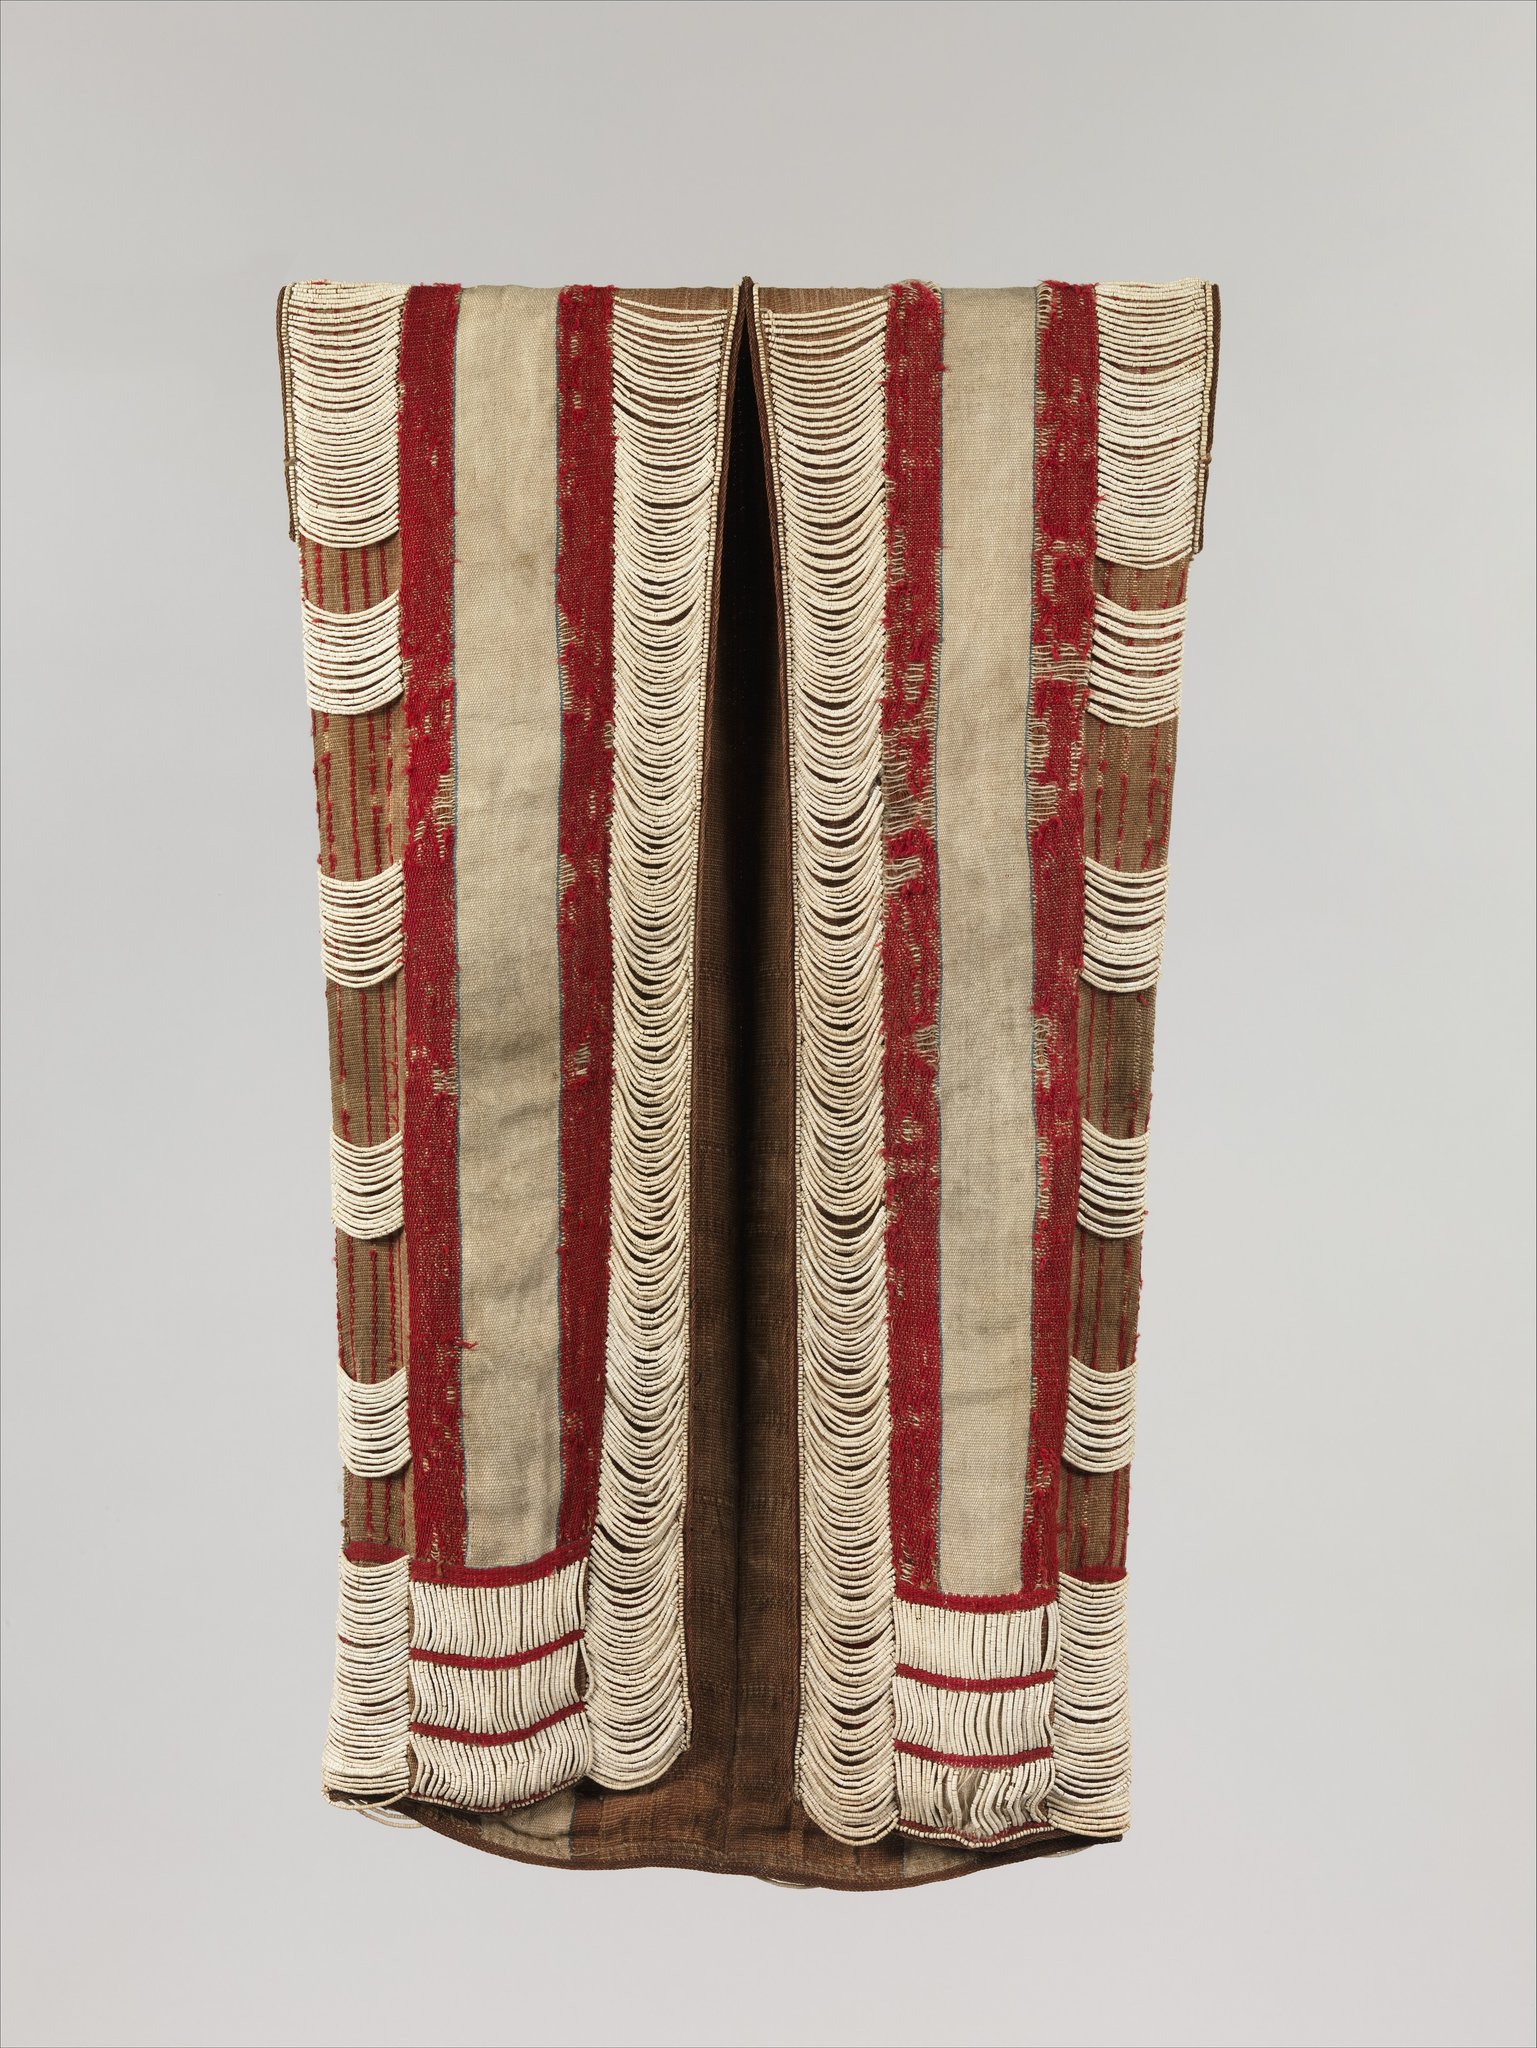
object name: overvest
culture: taiwanese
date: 1801-1900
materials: bone, cotton, wool